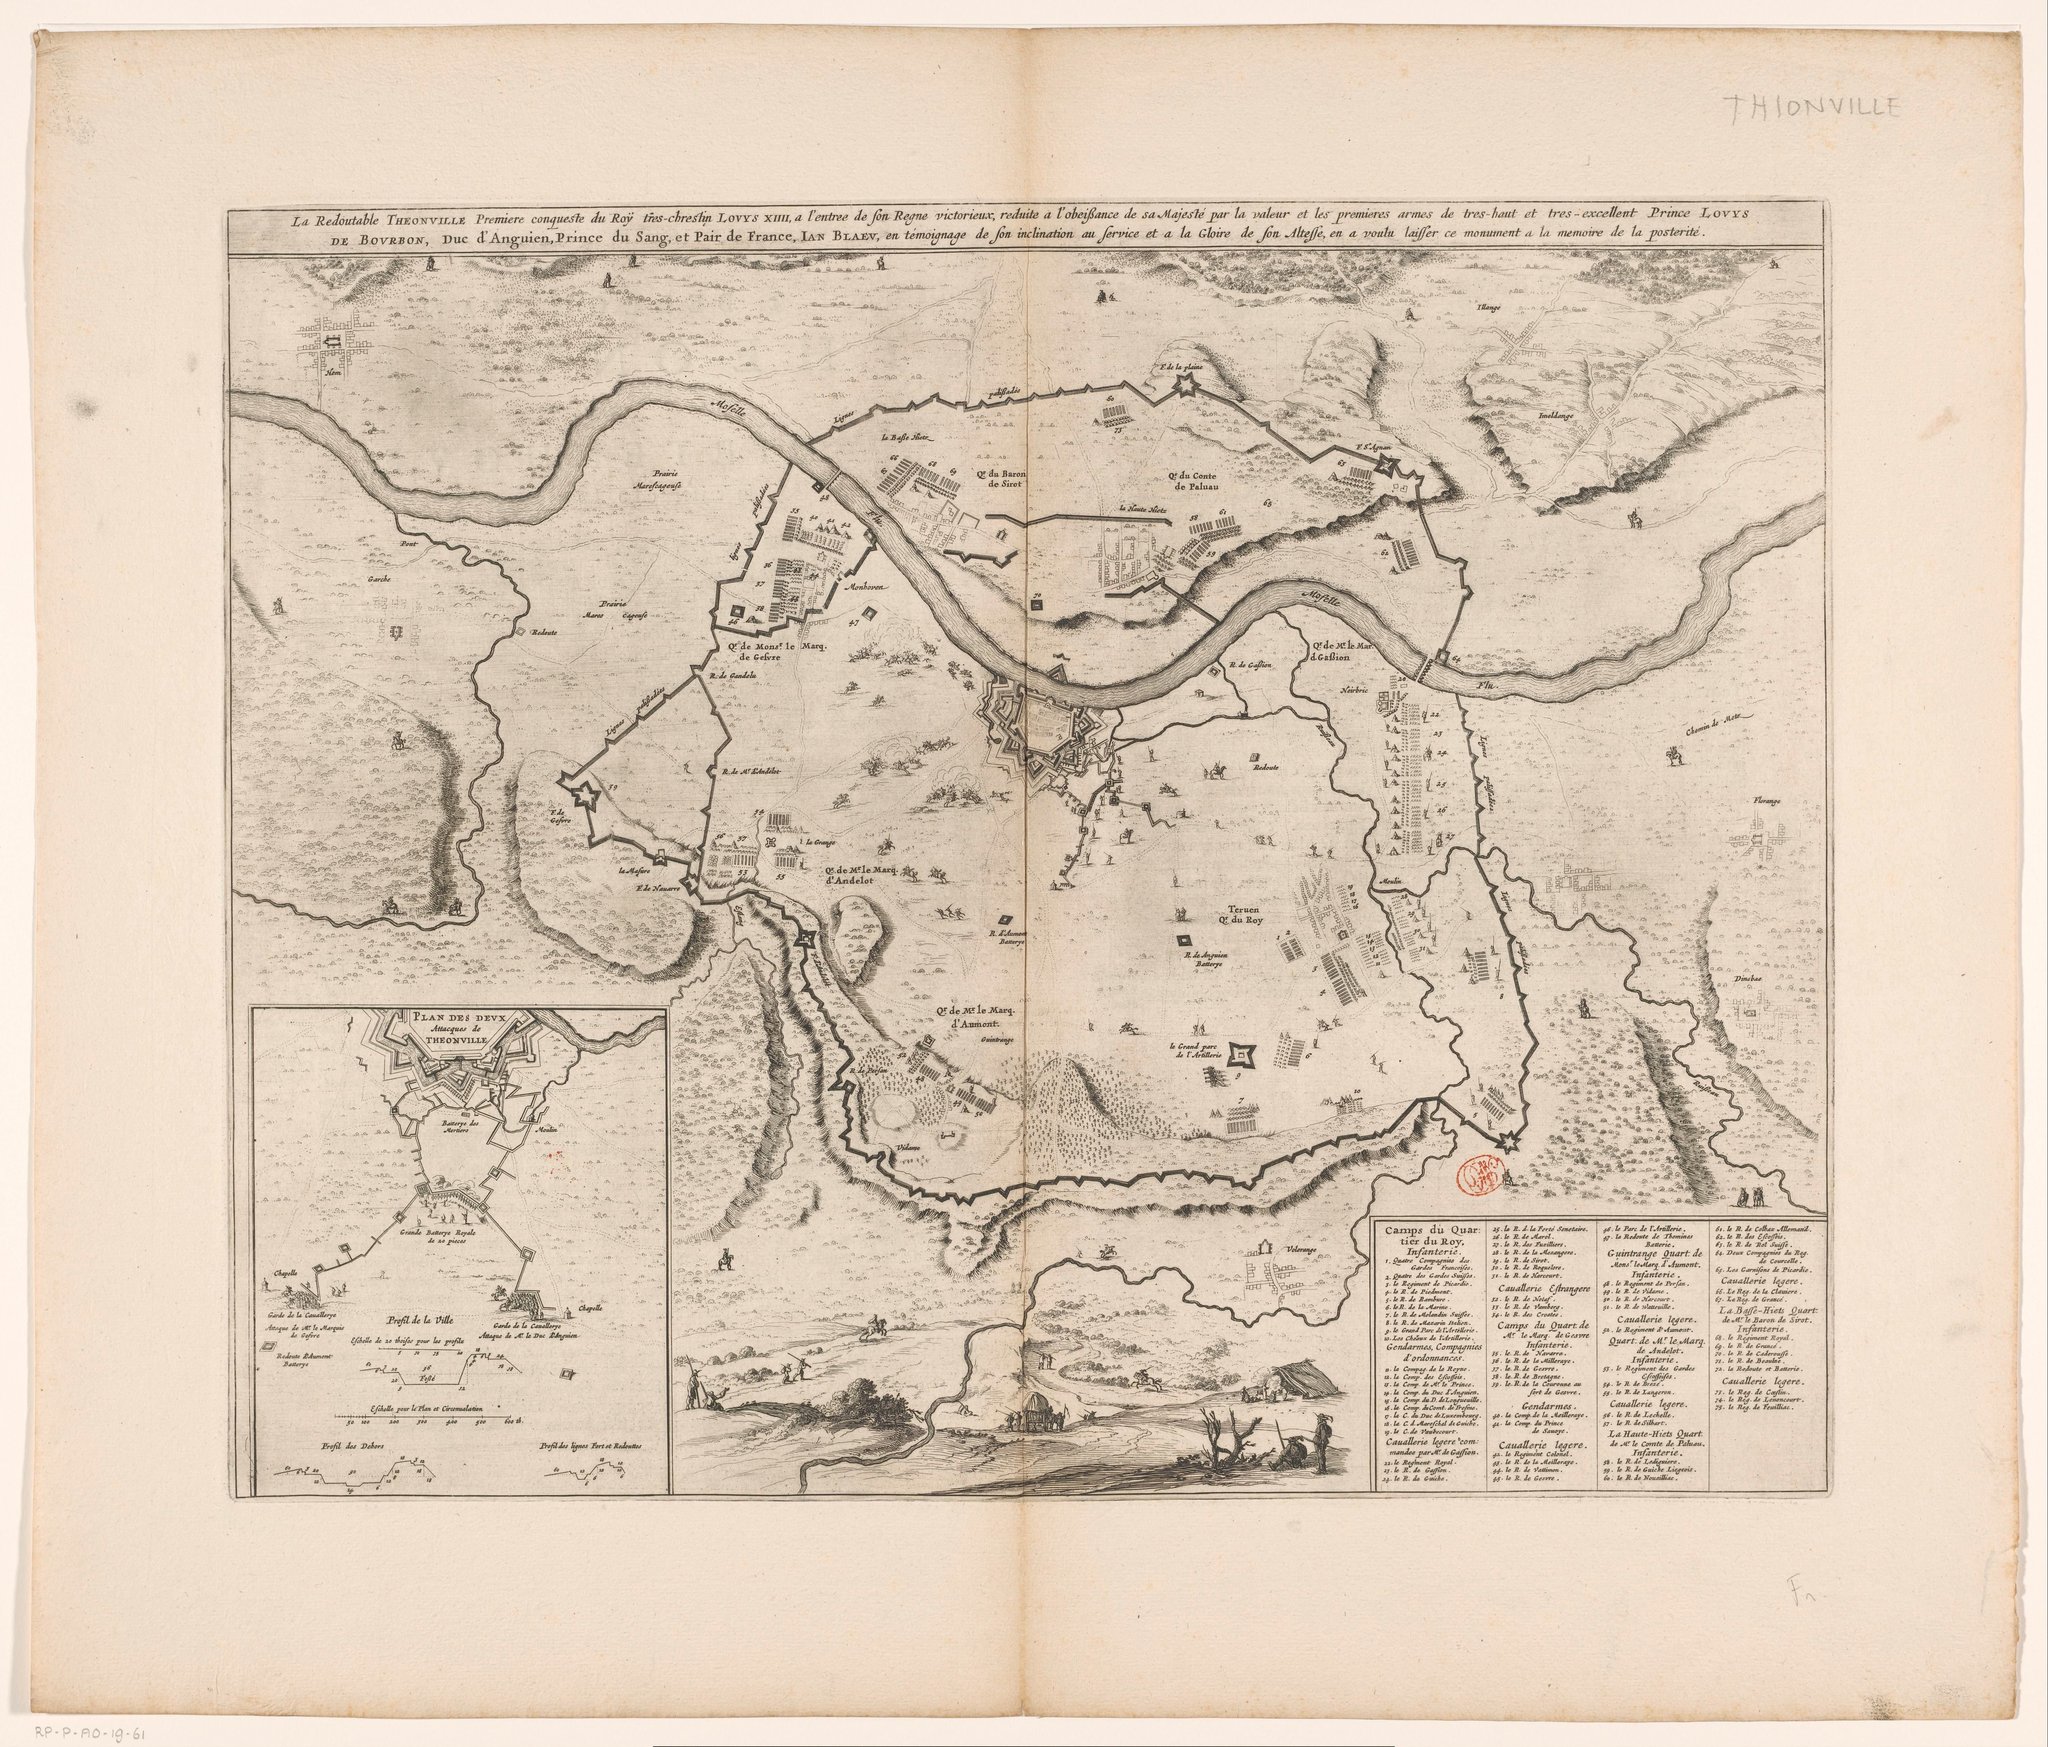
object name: print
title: Kaart van het beleg van Thionville, 1643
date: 1652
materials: paper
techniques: engraving, etching, letterpress printing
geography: amsterdam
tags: maps of separate countries or regions, siege, position war, maps of cities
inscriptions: collector's mark: Lugt 2228, collector's mark: Lugt 195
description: Kaart van het beleg van de stad Thionville door het Franse leger op de Spanjaarden in 1643. Bovenin de kaart een balk met titel. Linksonder een inzet met een kaart van twee aanvallen op de stad. Rechtsonder een kader met legenda: 1-75. Met Nederlandse tekst op verso.